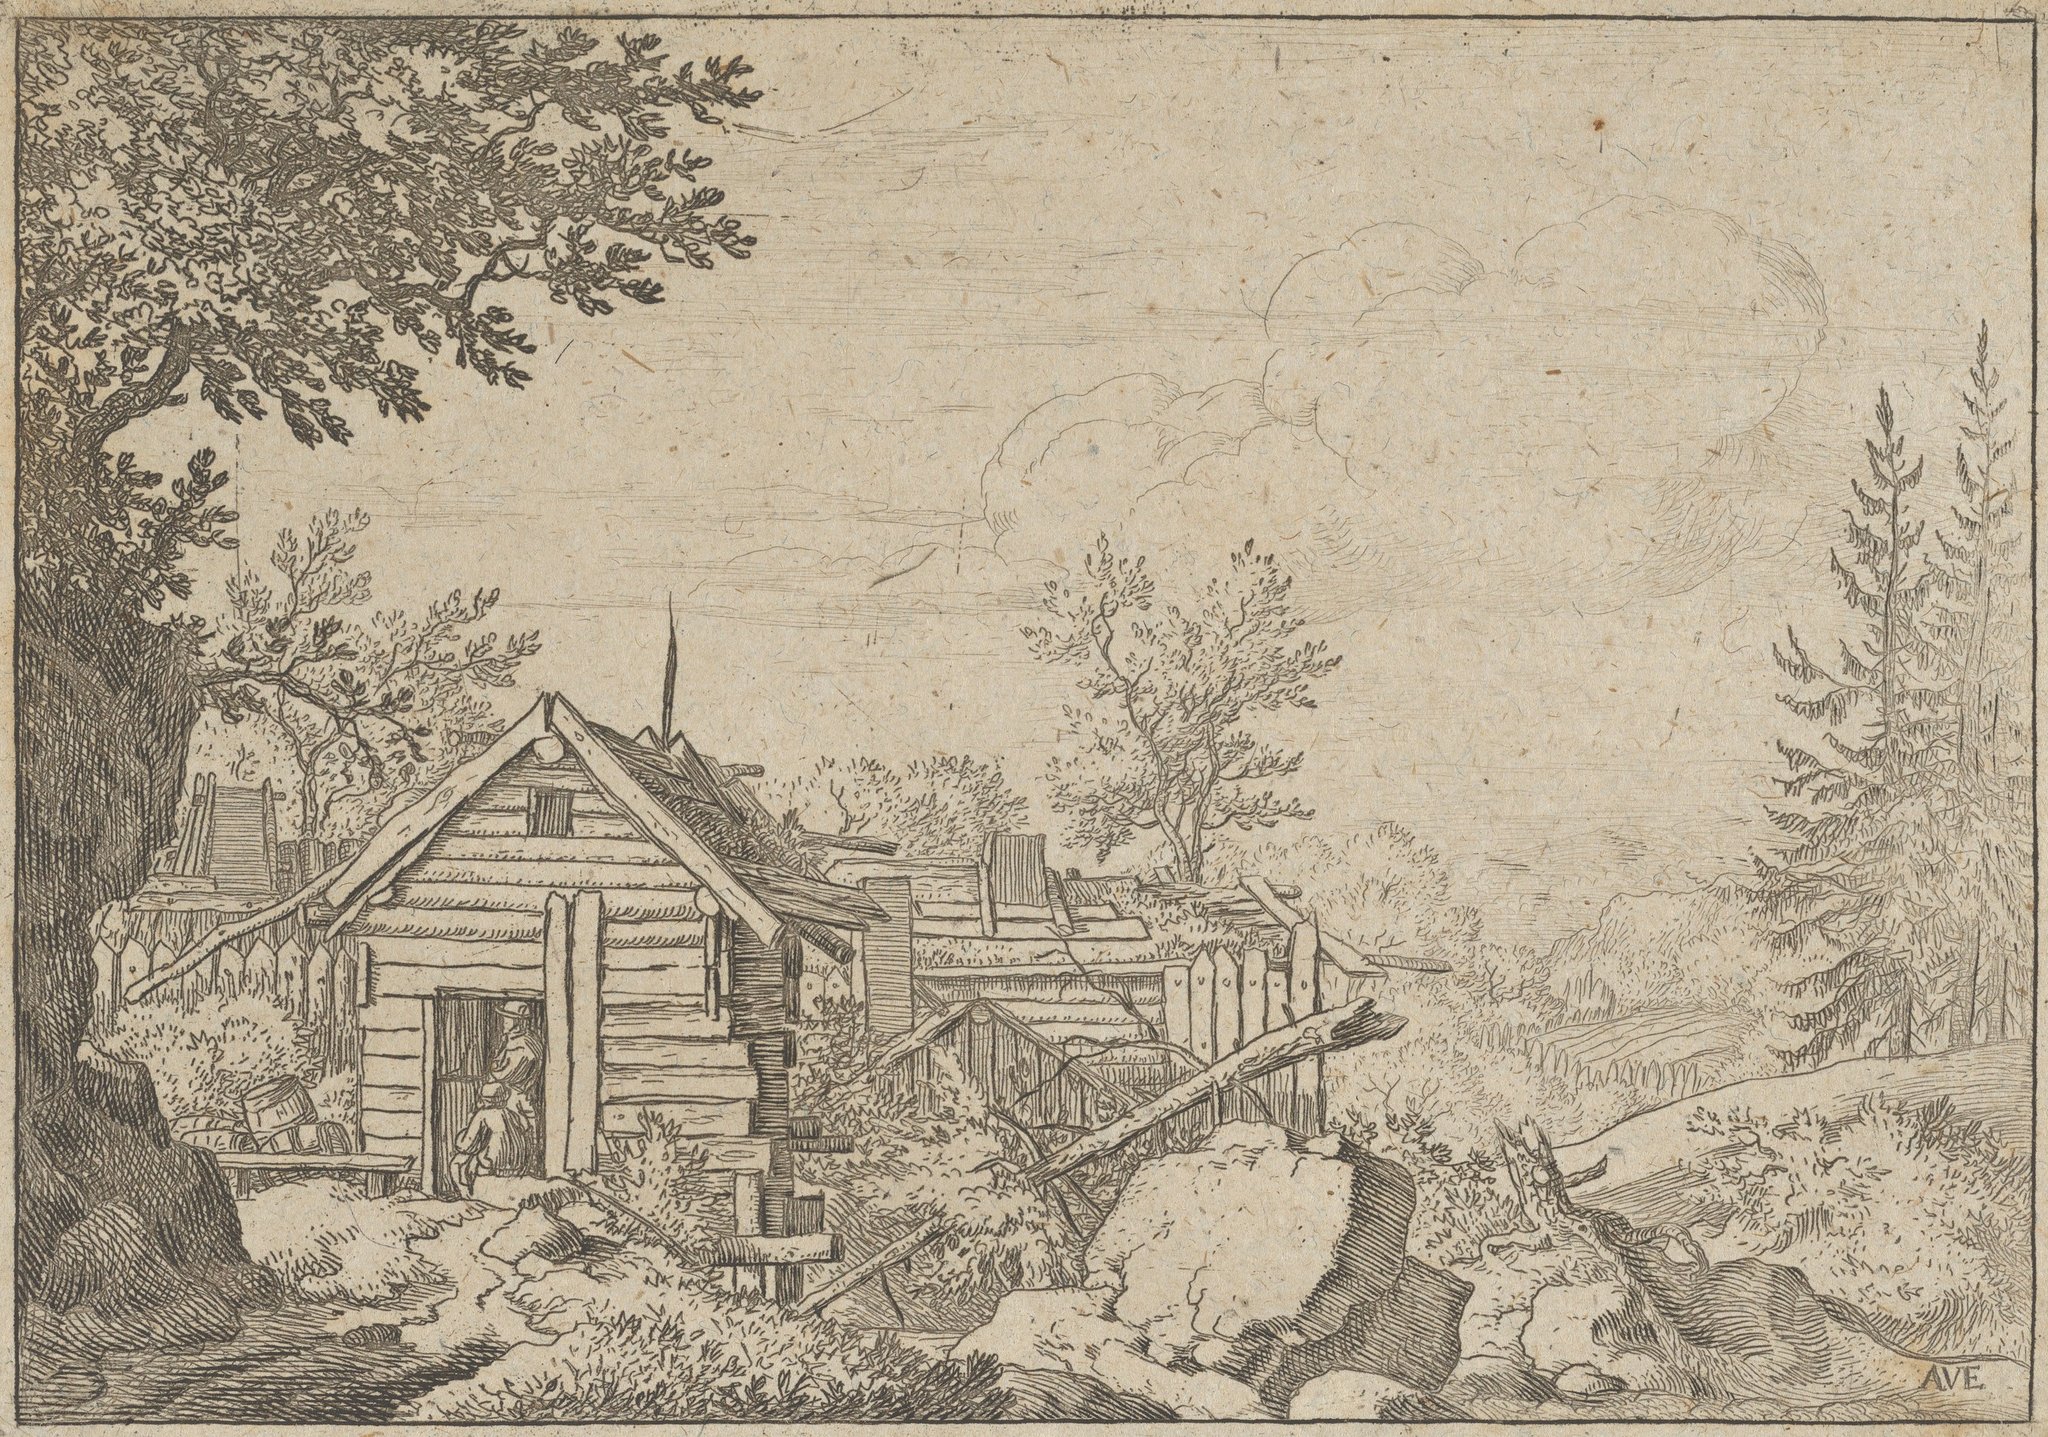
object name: print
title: Two Men in the Door of the Hut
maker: allart van everdingen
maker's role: artist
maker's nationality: dutch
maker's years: 1621-1675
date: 1601-1700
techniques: engraving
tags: houses,men,landscapes,trees